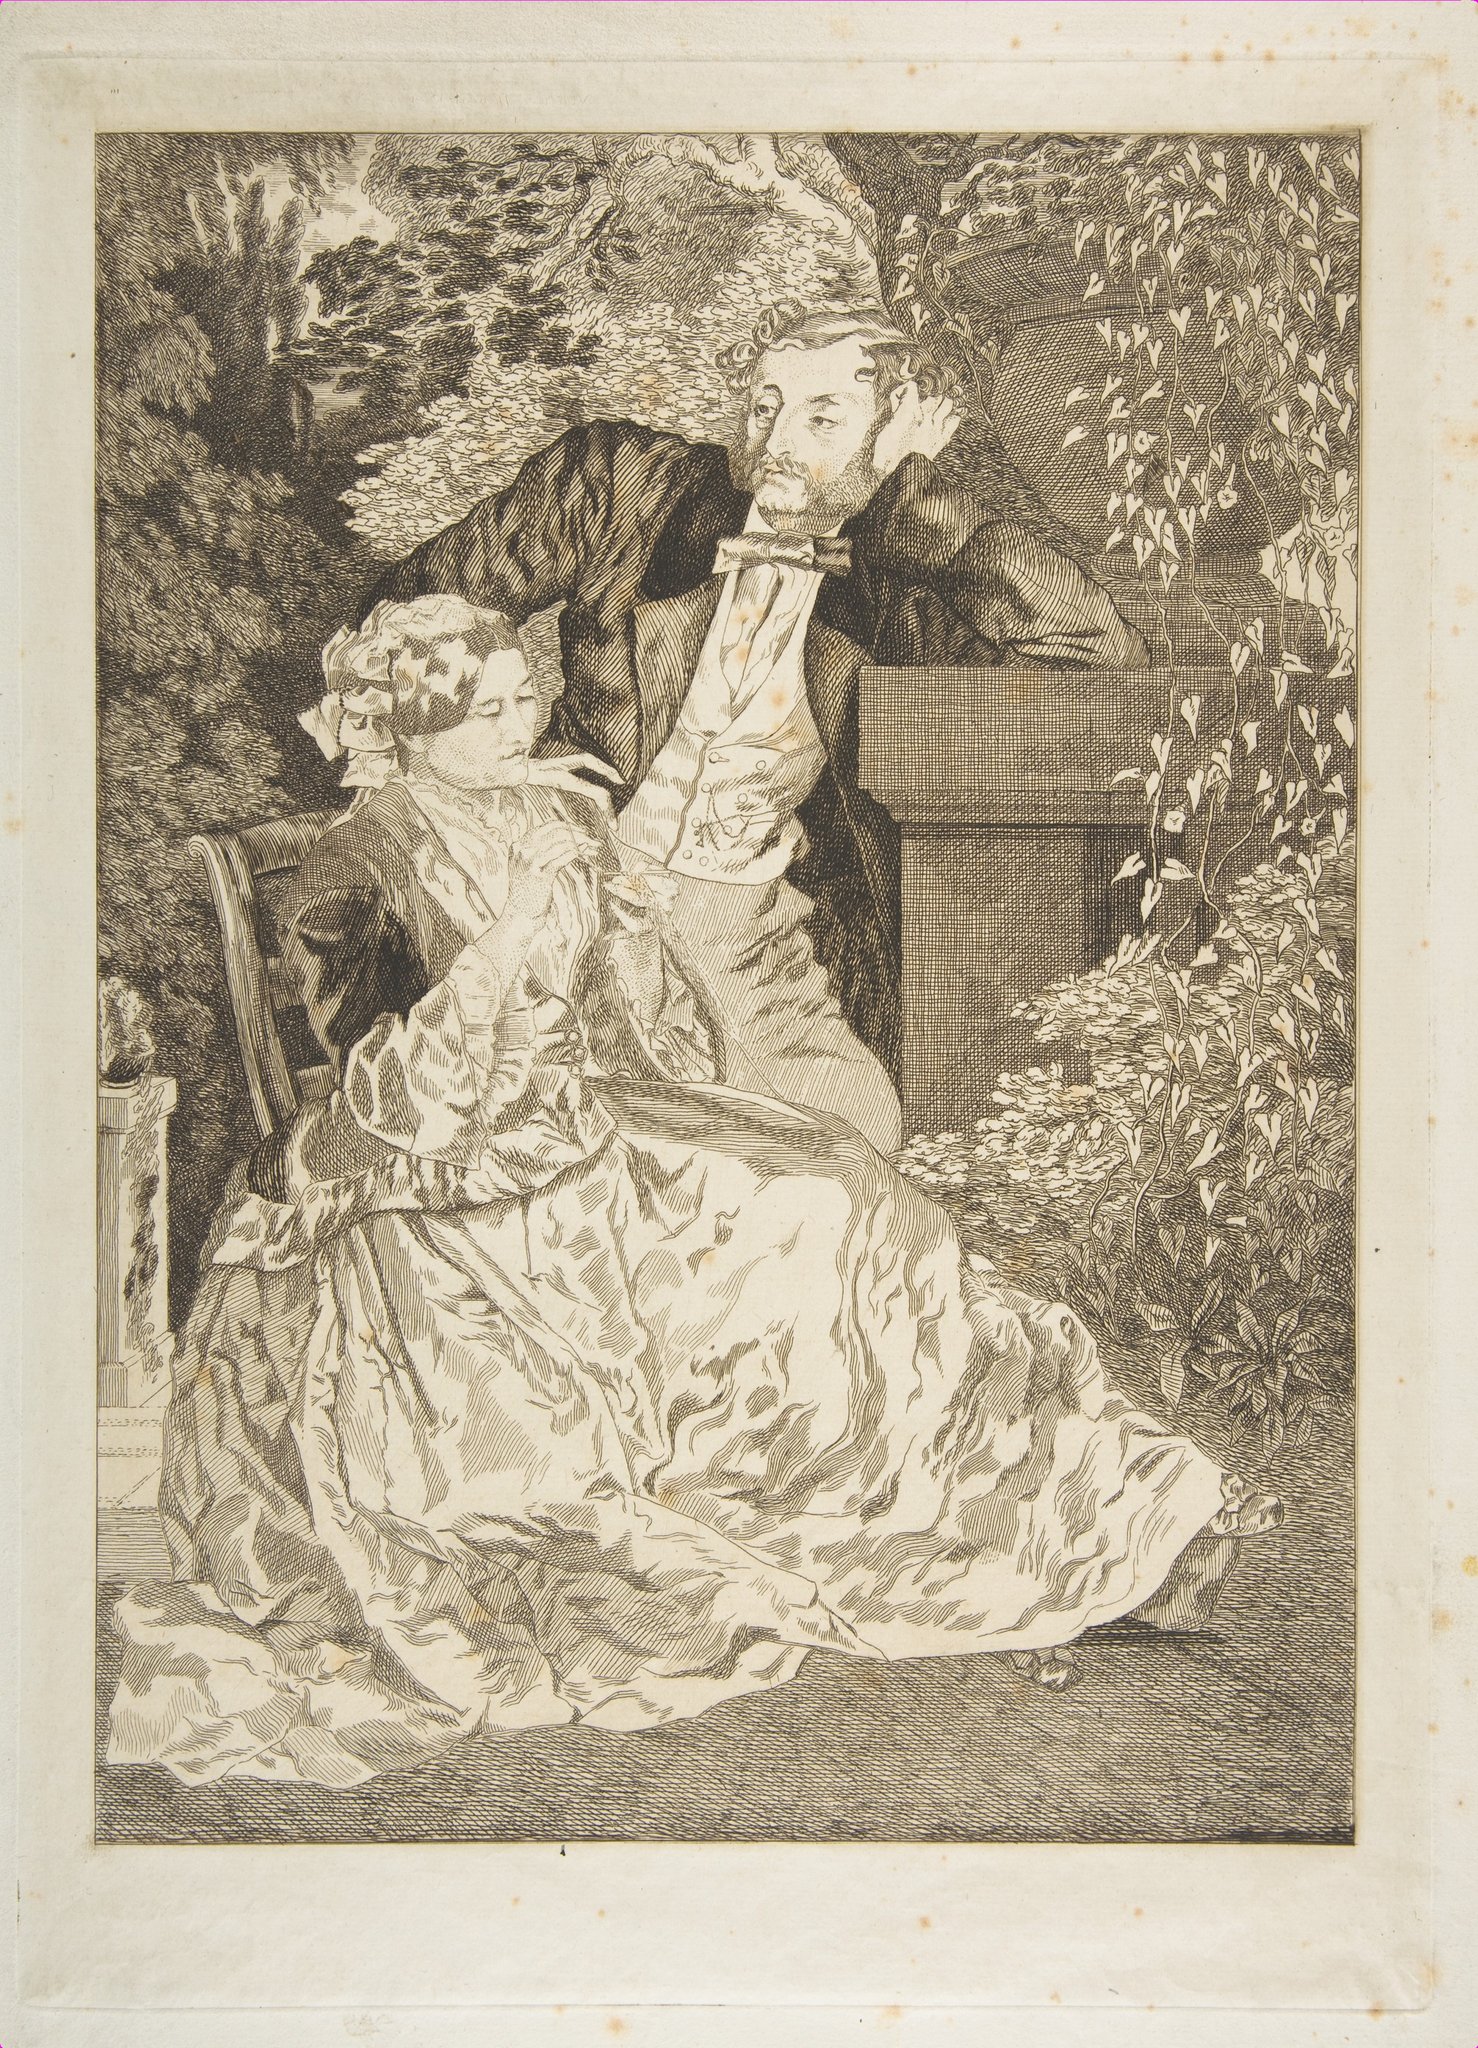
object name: print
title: La Broderie à l'aiguille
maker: félix bracquemond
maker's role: artist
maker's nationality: french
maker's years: 1833-1914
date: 1855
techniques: engraving, etching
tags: men,women